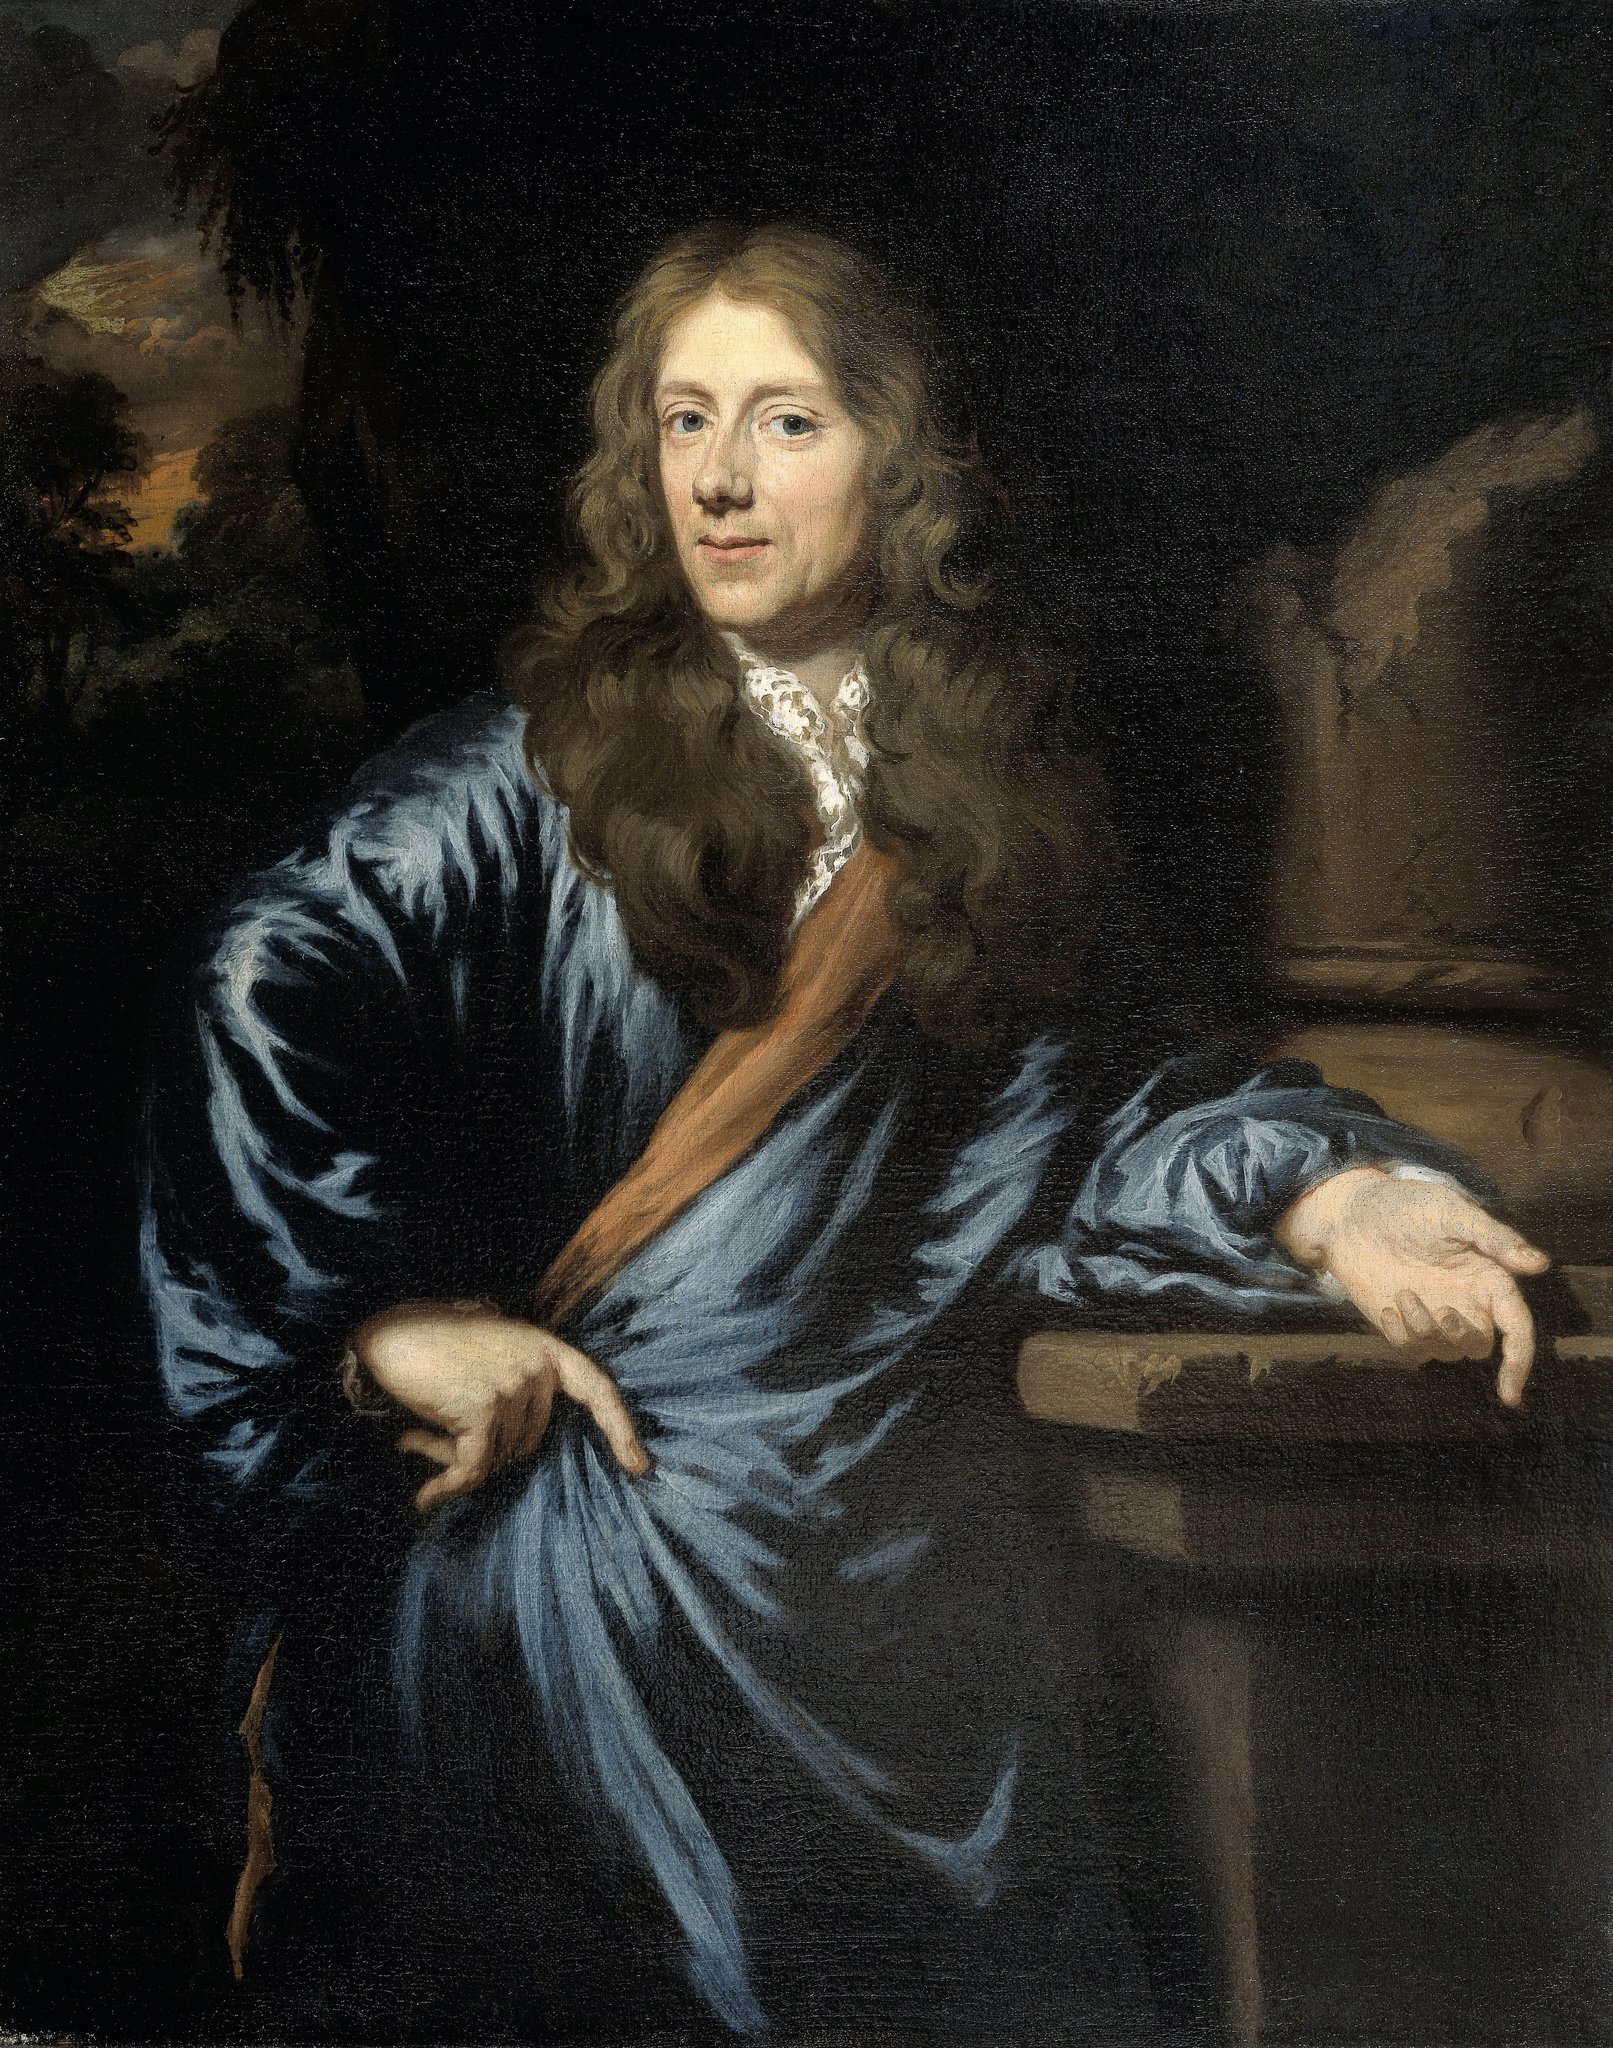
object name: painting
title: Portrait of Willem Pottey, Lawyer and Accountant-General of Flushing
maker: nicolaes maes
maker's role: draughtsman, painter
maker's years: 1634-1693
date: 1686-1693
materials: canvas, oil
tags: flushing, historical persons, lawyer, attorney at law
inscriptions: signature: ‘Maes’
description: Portret van Willem Pottey, advocaat en rekenmeester-generaal te Vlissingen. Kniestuk, staand naast een zuil, gebarend met de linkerhand. Pendant van SK-A-1646.